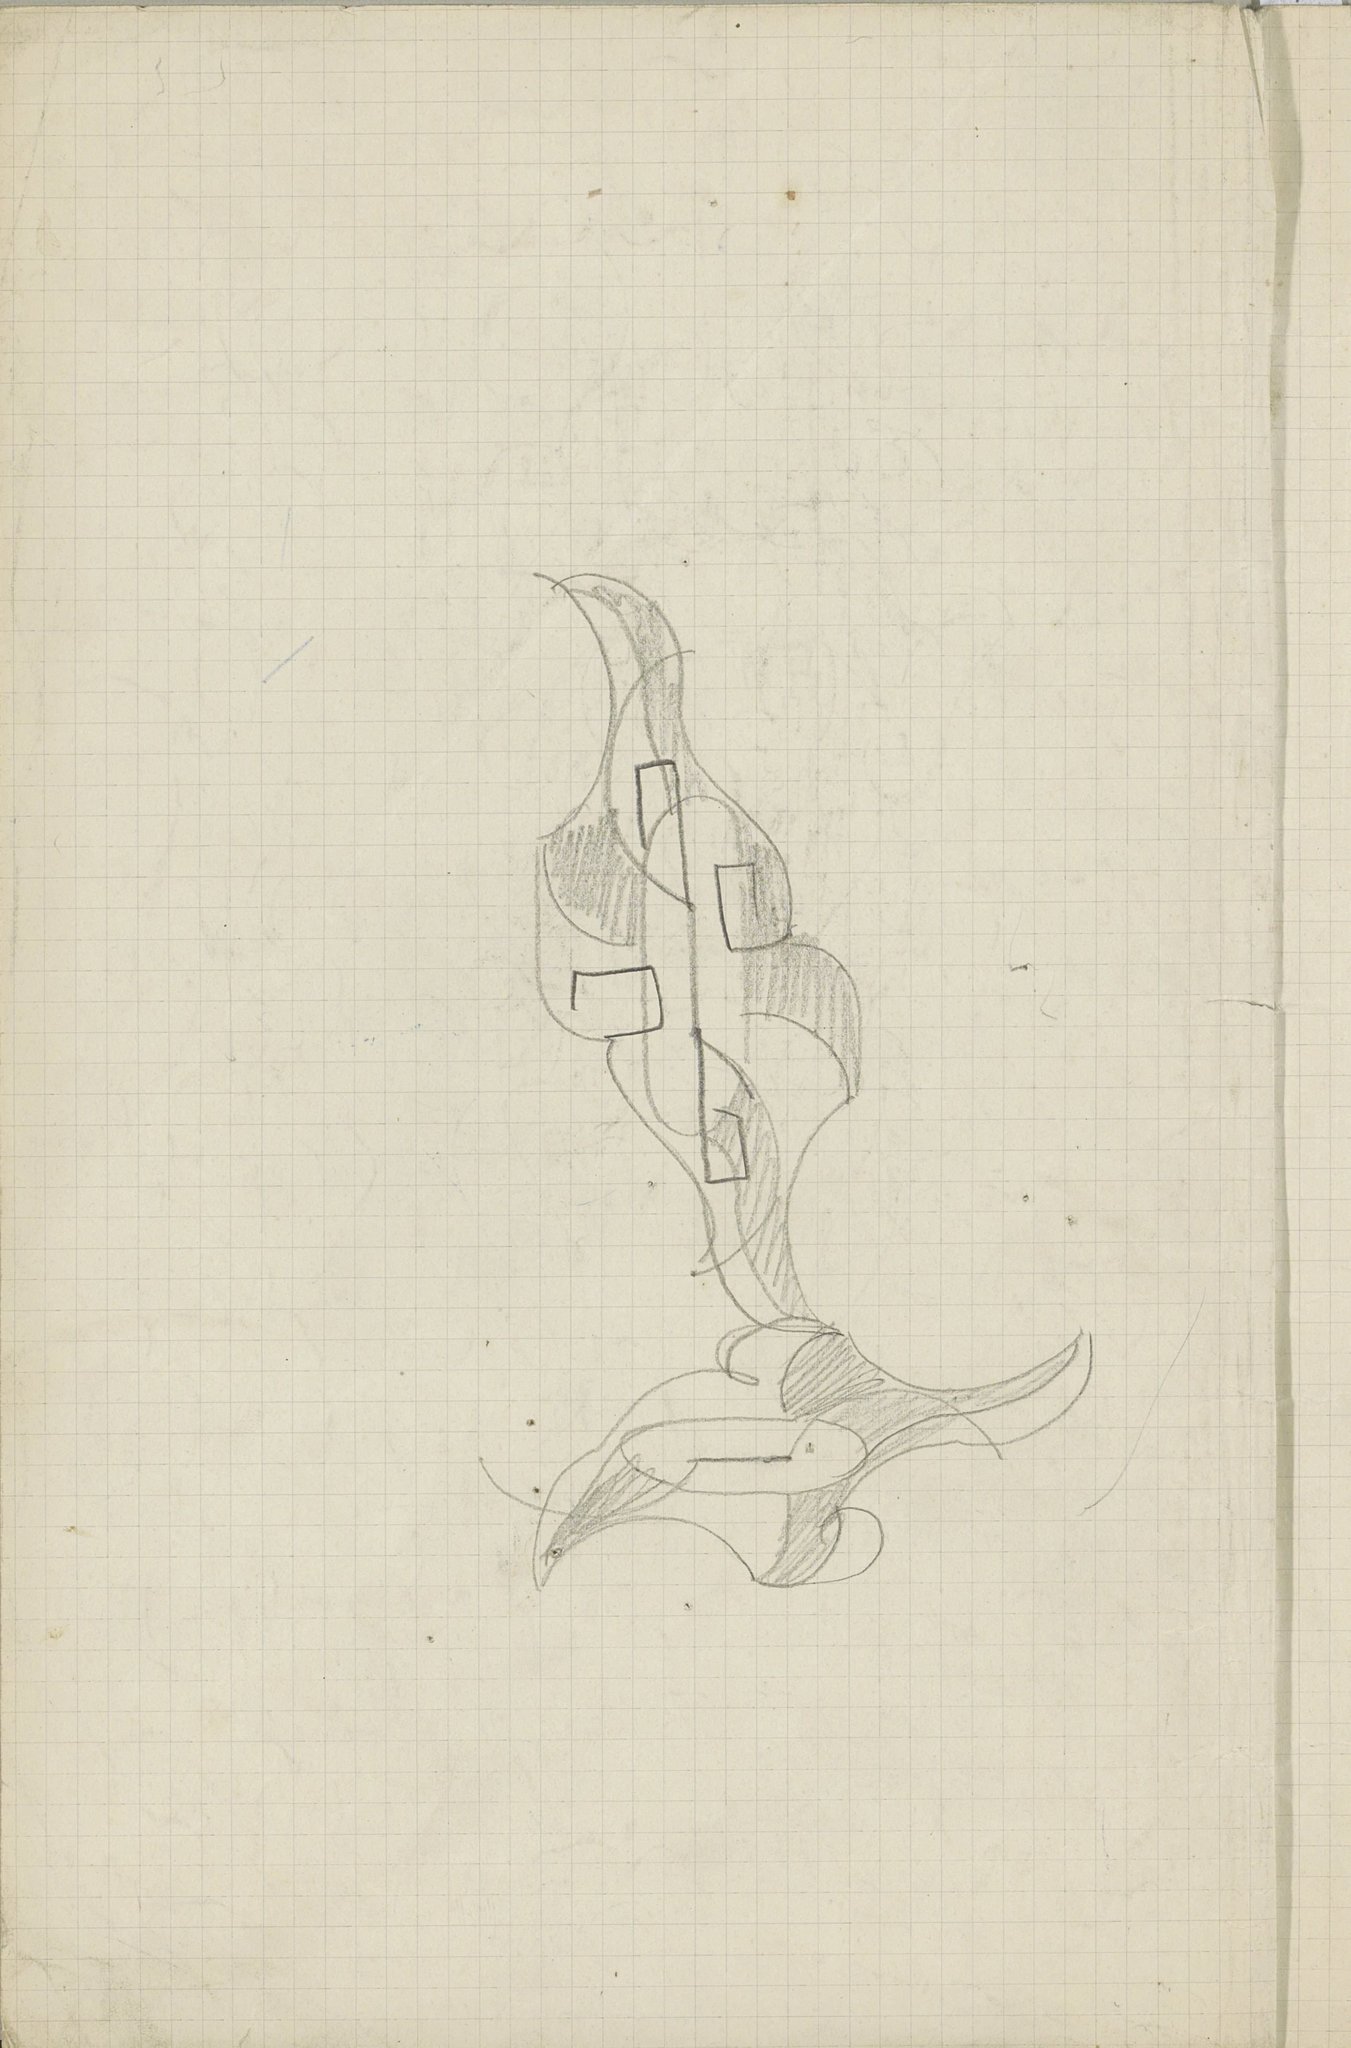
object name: sketchbook leaf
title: Fantasieornament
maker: carel adolph lion cachet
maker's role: draughtsman, print maker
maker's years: 1864-1945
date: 1874-1945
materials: pencil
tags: fantasy ornament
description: Blad 1 verso uit een schetsboek met 9 bladen.